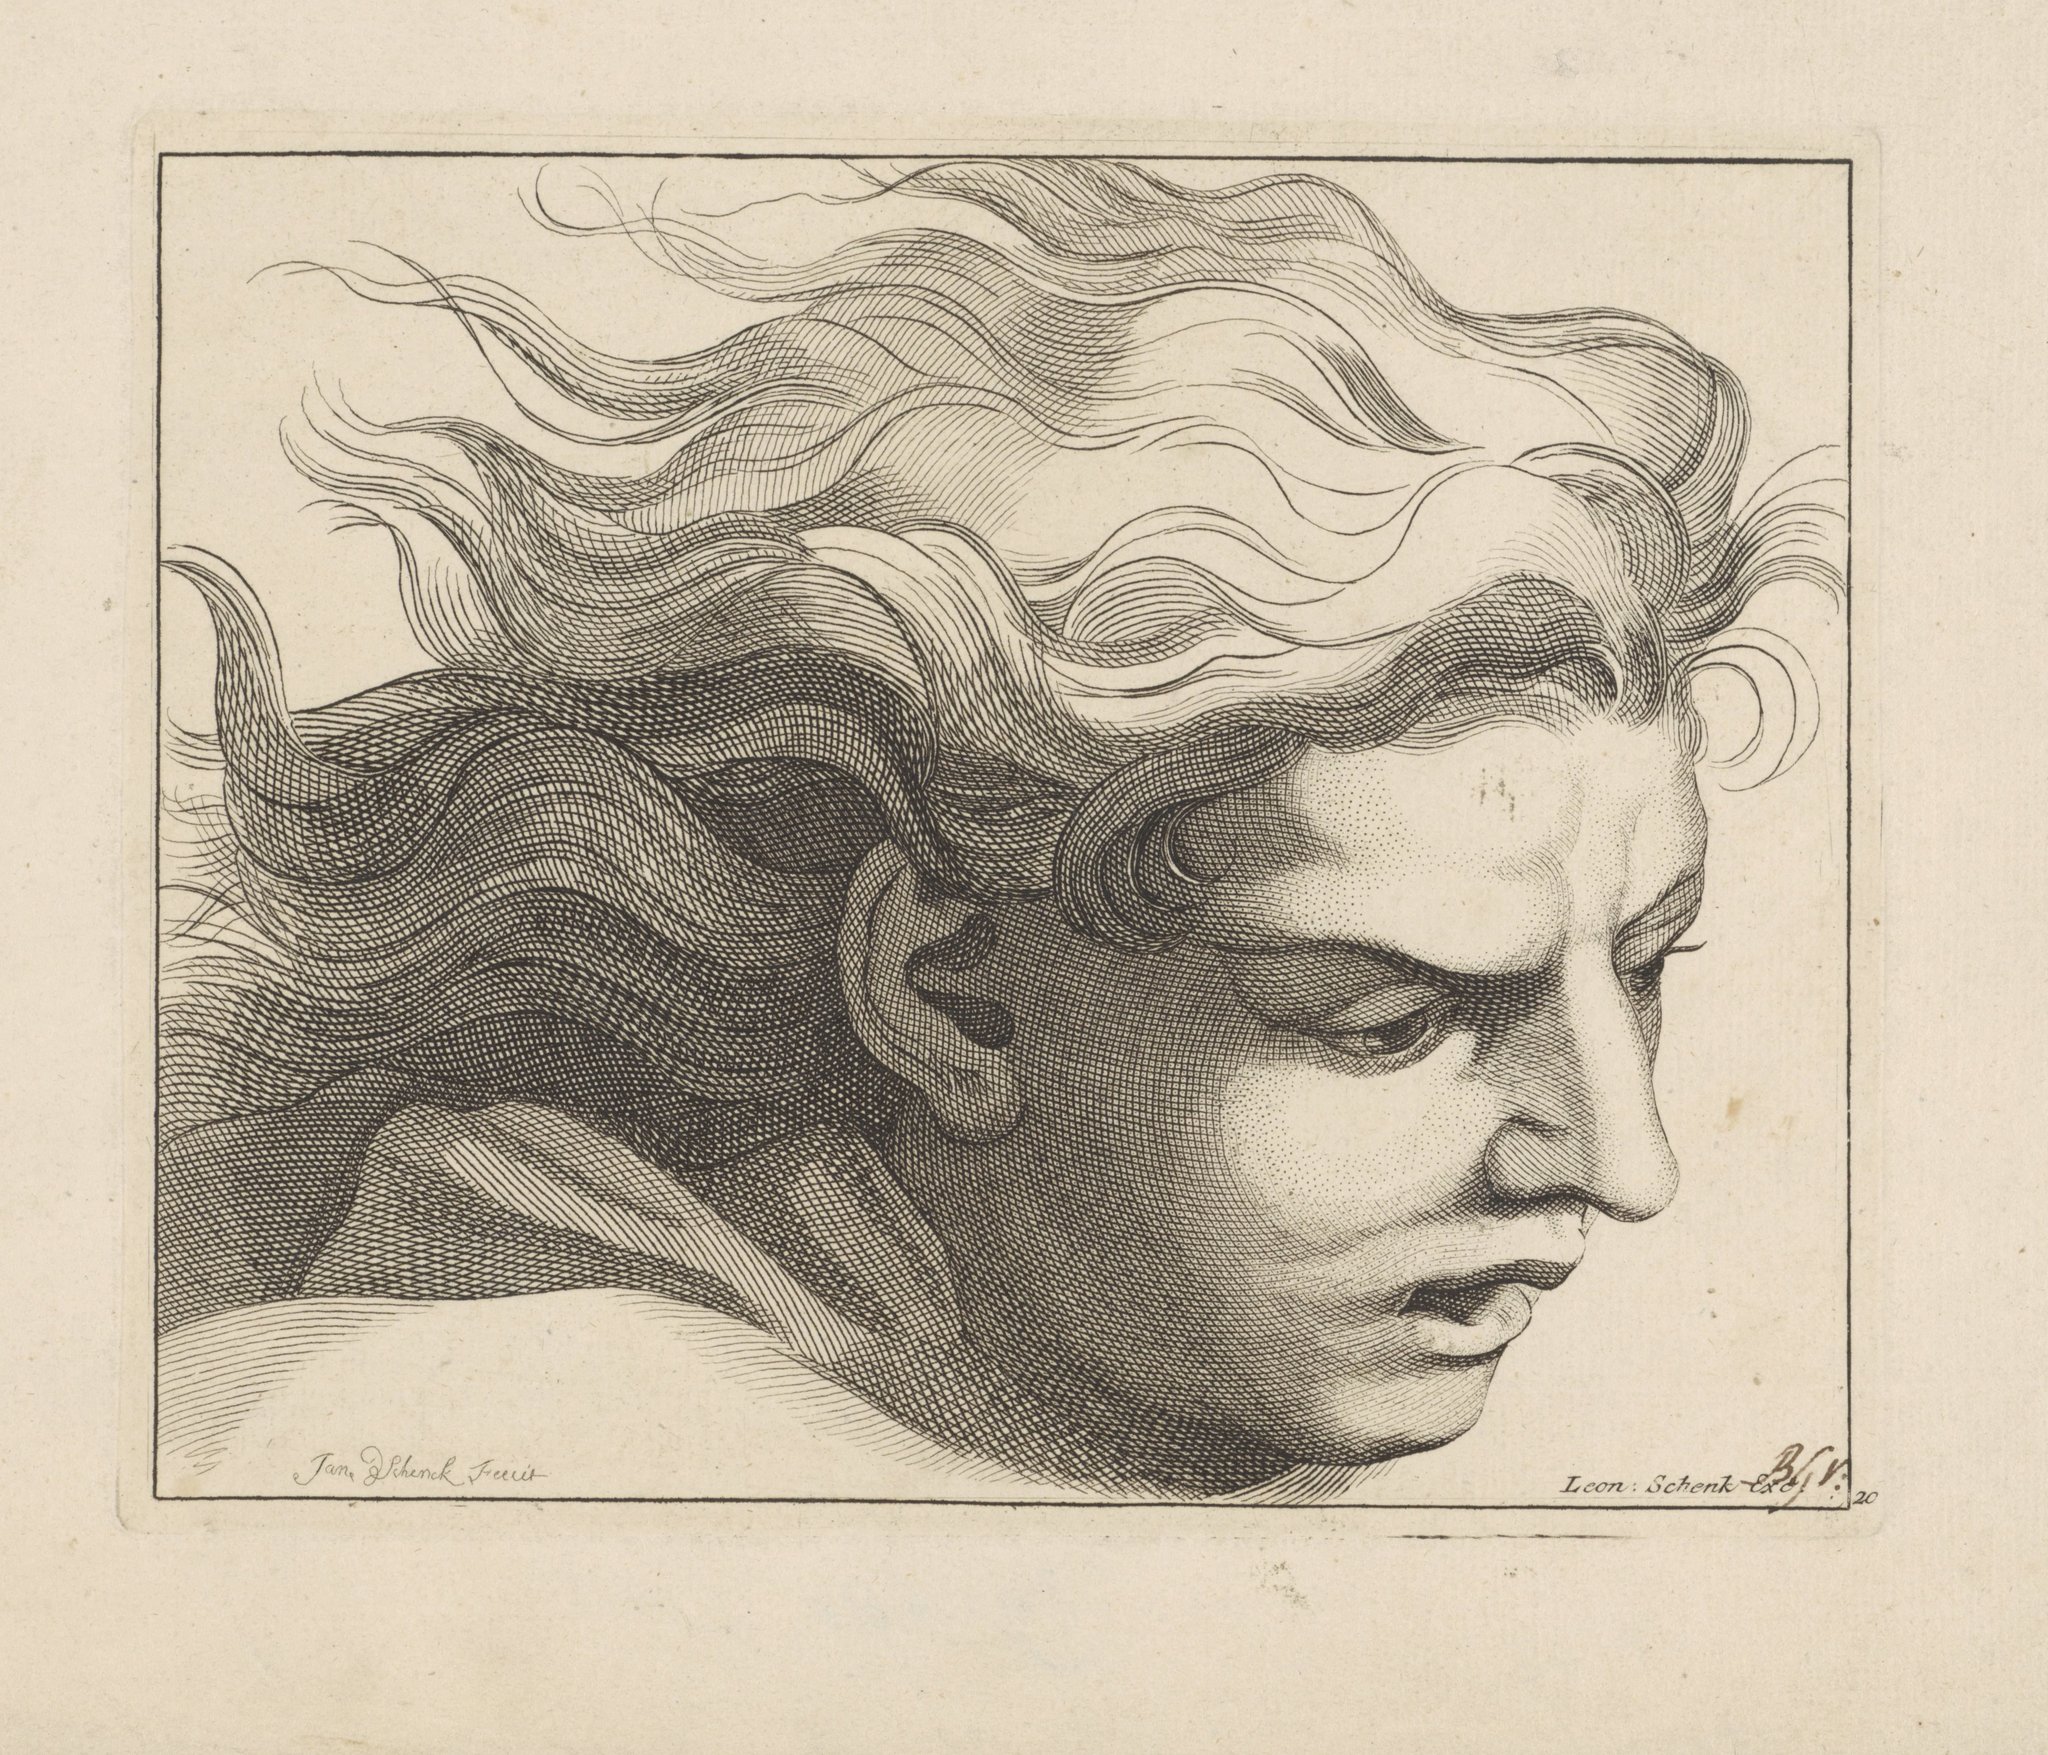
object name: print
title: Studies van menselijke hoofden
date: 1710-1767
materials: paper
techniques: engraving, etching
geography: amsterdam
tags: head (human), tousled hair (+ three-quarter view)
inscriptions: collector's mark: Lugt 2166, collector's mark: Lugt 2760, initials: ‘BG’, initials: ‘BGV:’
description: Studie van een mannenhoofd, driekwart naar links, met golvende haren en een geopende mond. Hij kijkt naar beneden.